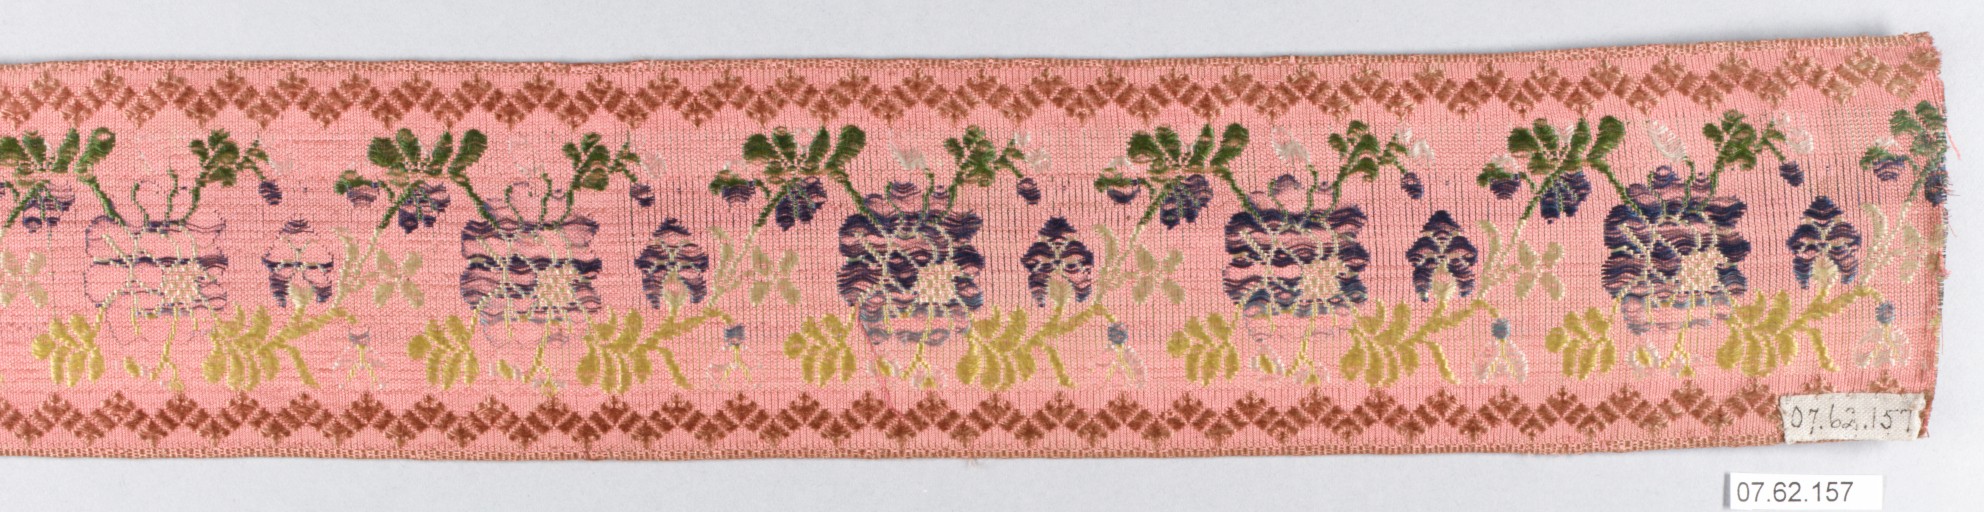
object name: ribbon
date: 1715-1774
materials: silk